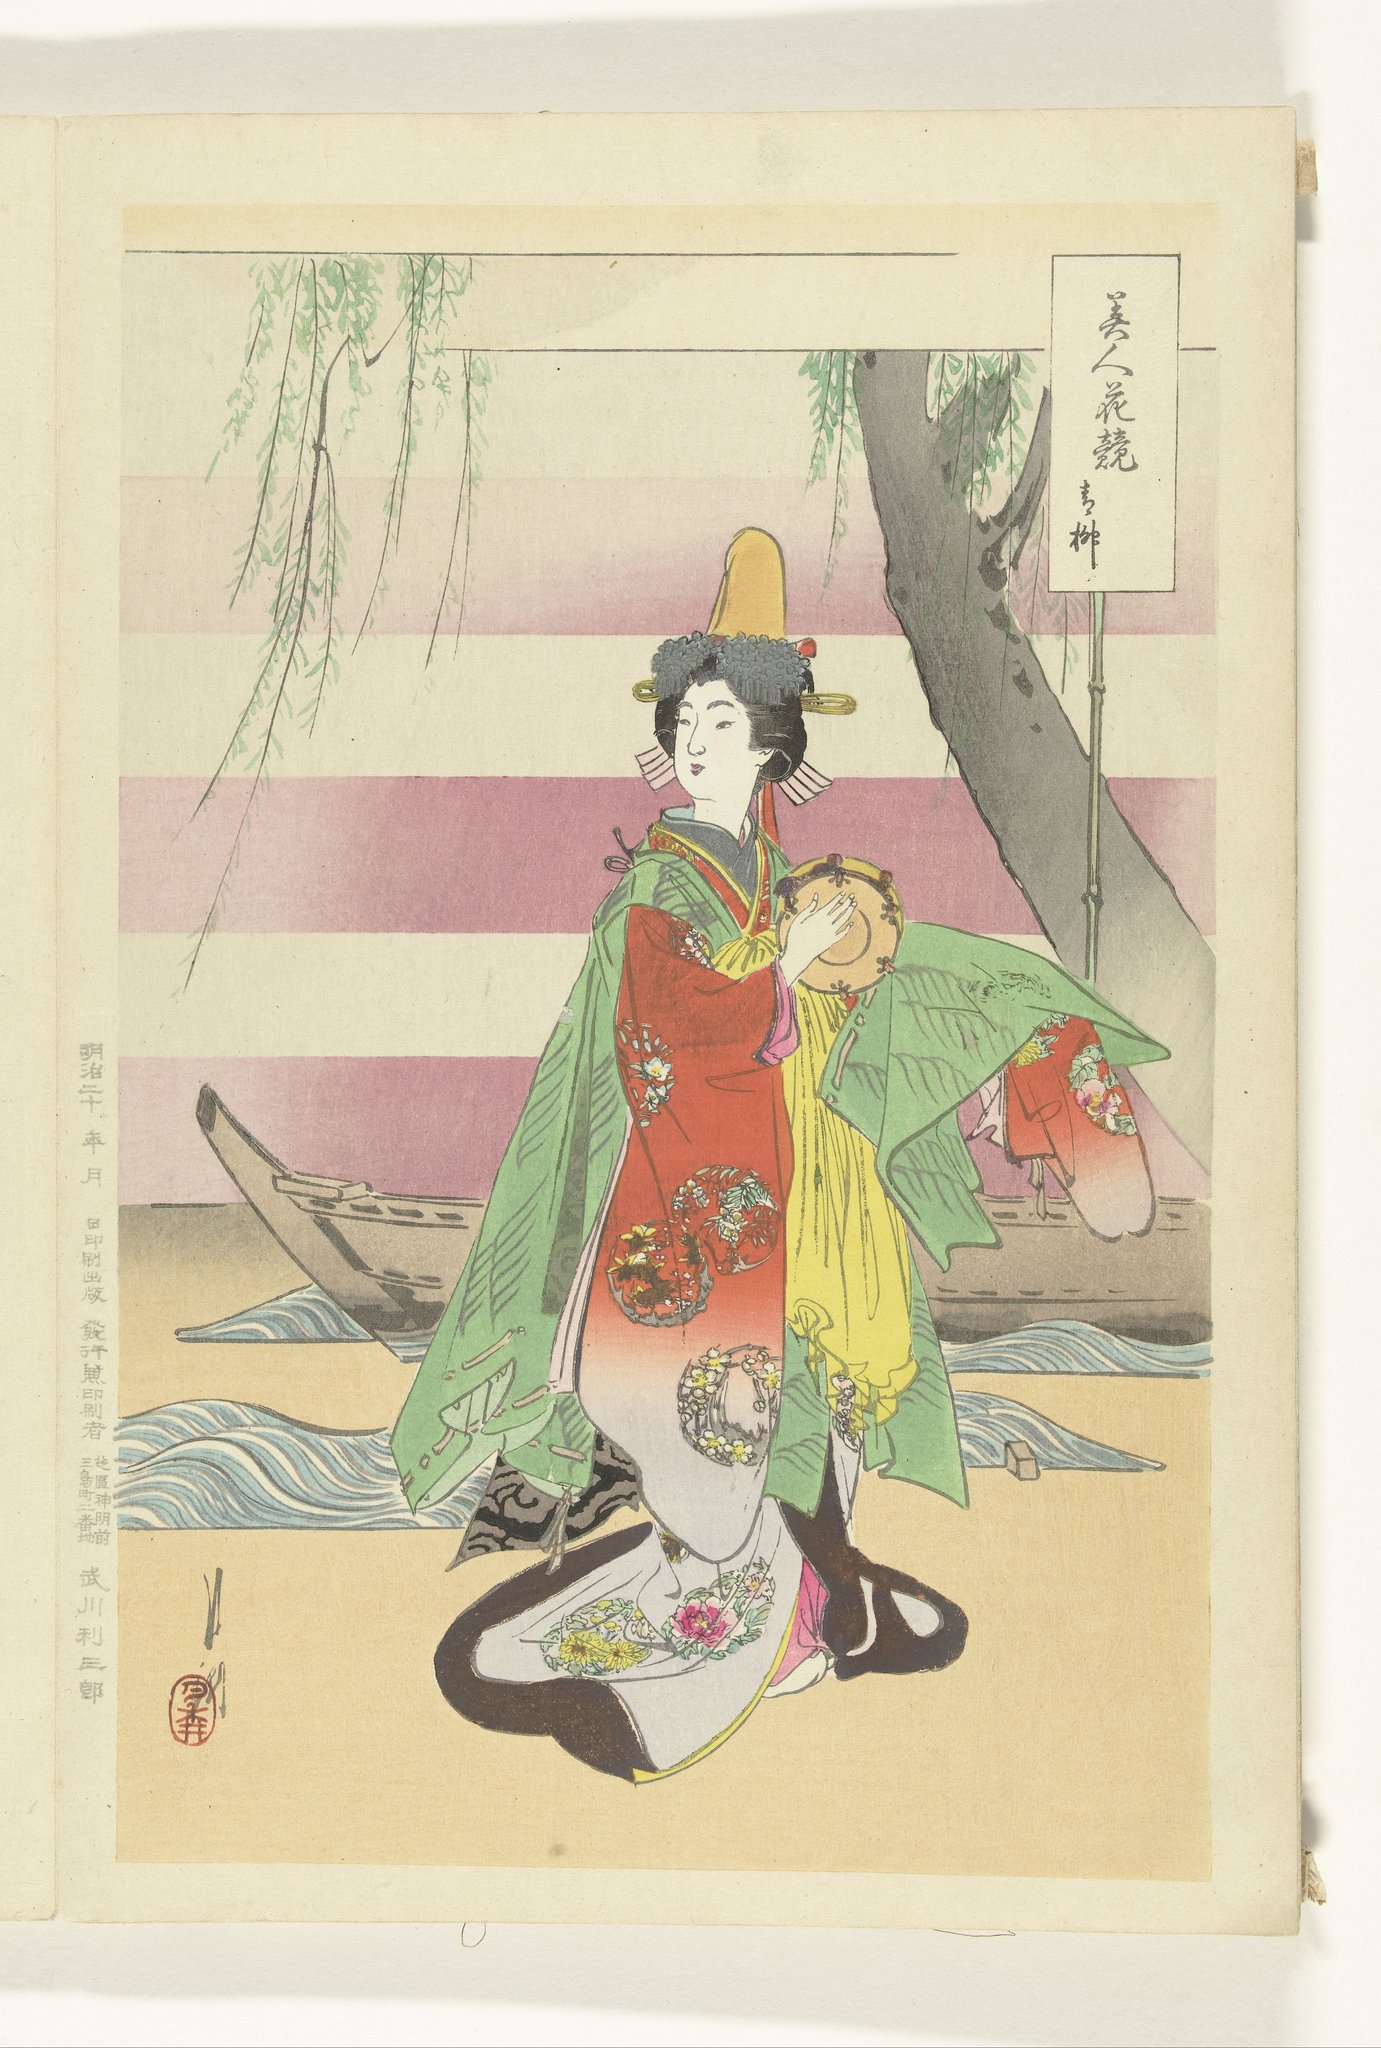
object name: print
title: Bijin hana kurabe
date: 1887-1896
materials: paper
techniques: blind stamped, woodcut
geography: japan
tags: woman dancing alone, drum (musical instrument), boat propelled by man or animal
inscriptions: collector's mark: Lugt 2760, collector's mark: Lugt 2228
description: Vrouw met kleine trommel in handen, dansend onder boom, bij boot.